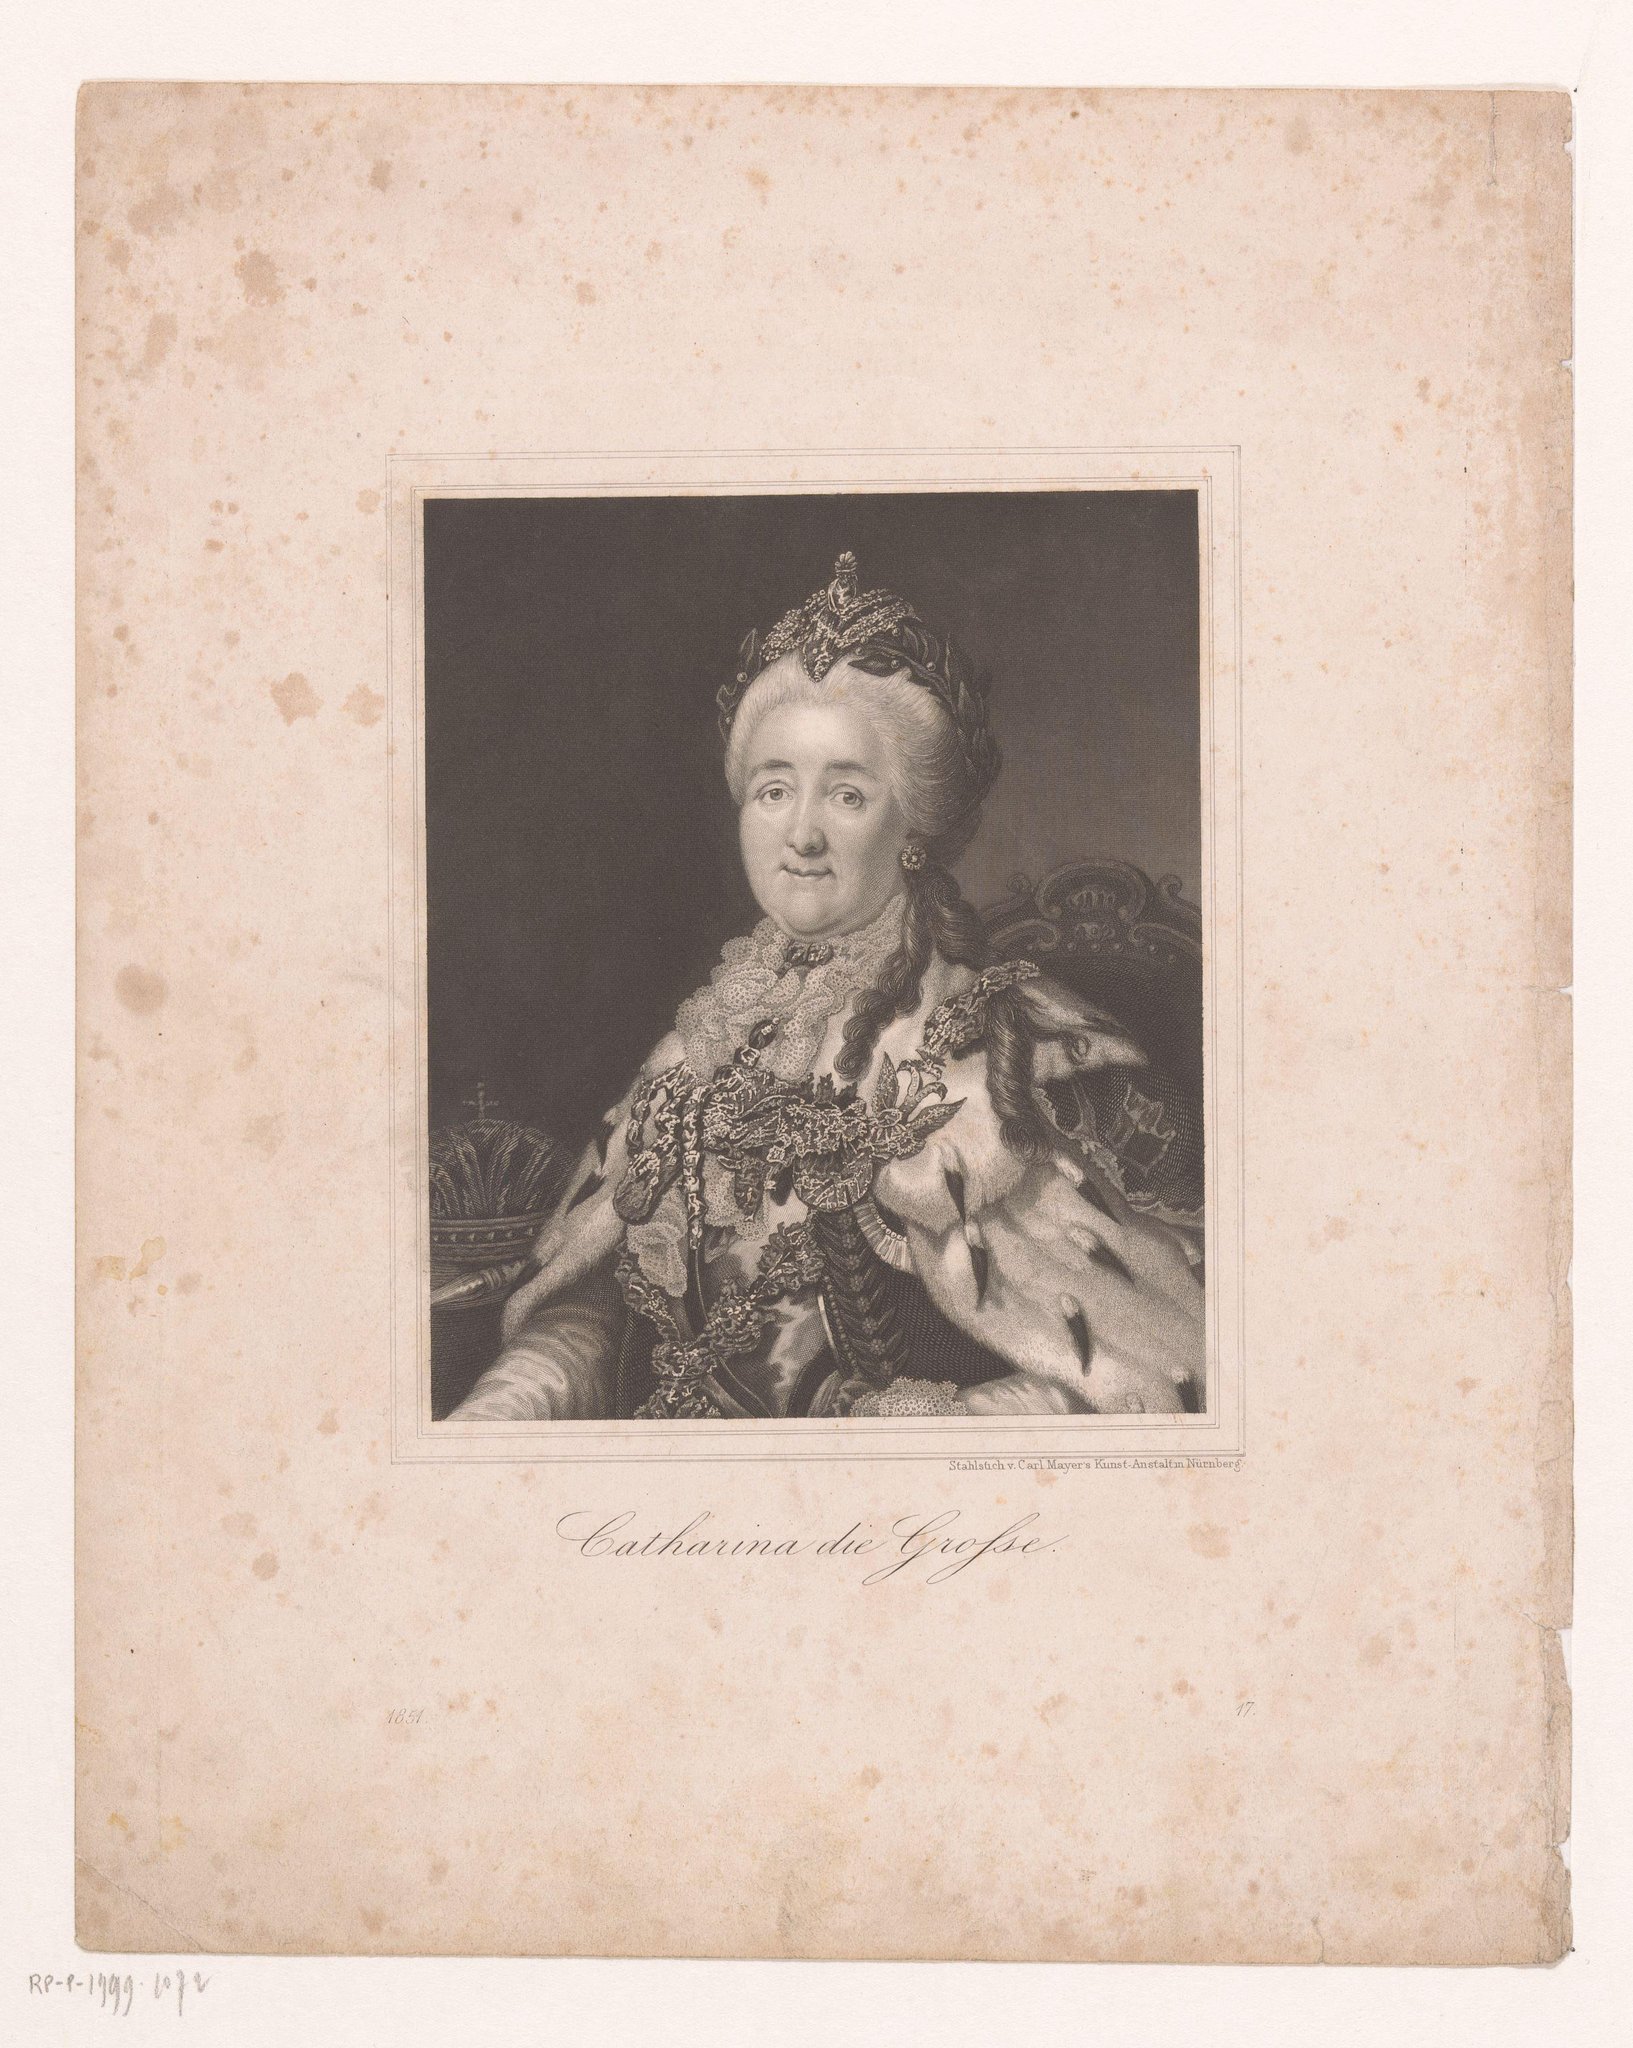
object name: print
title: Portret Catharina de grote, keizerin van Rusland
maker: carl mayer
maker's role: print maker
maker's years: 1798-1868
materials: paper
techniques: engraving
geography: nuremberg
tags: catharina de grote, historical persons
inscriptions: collector's mark: Lugt 2228, collector's mark: Lugt 2760